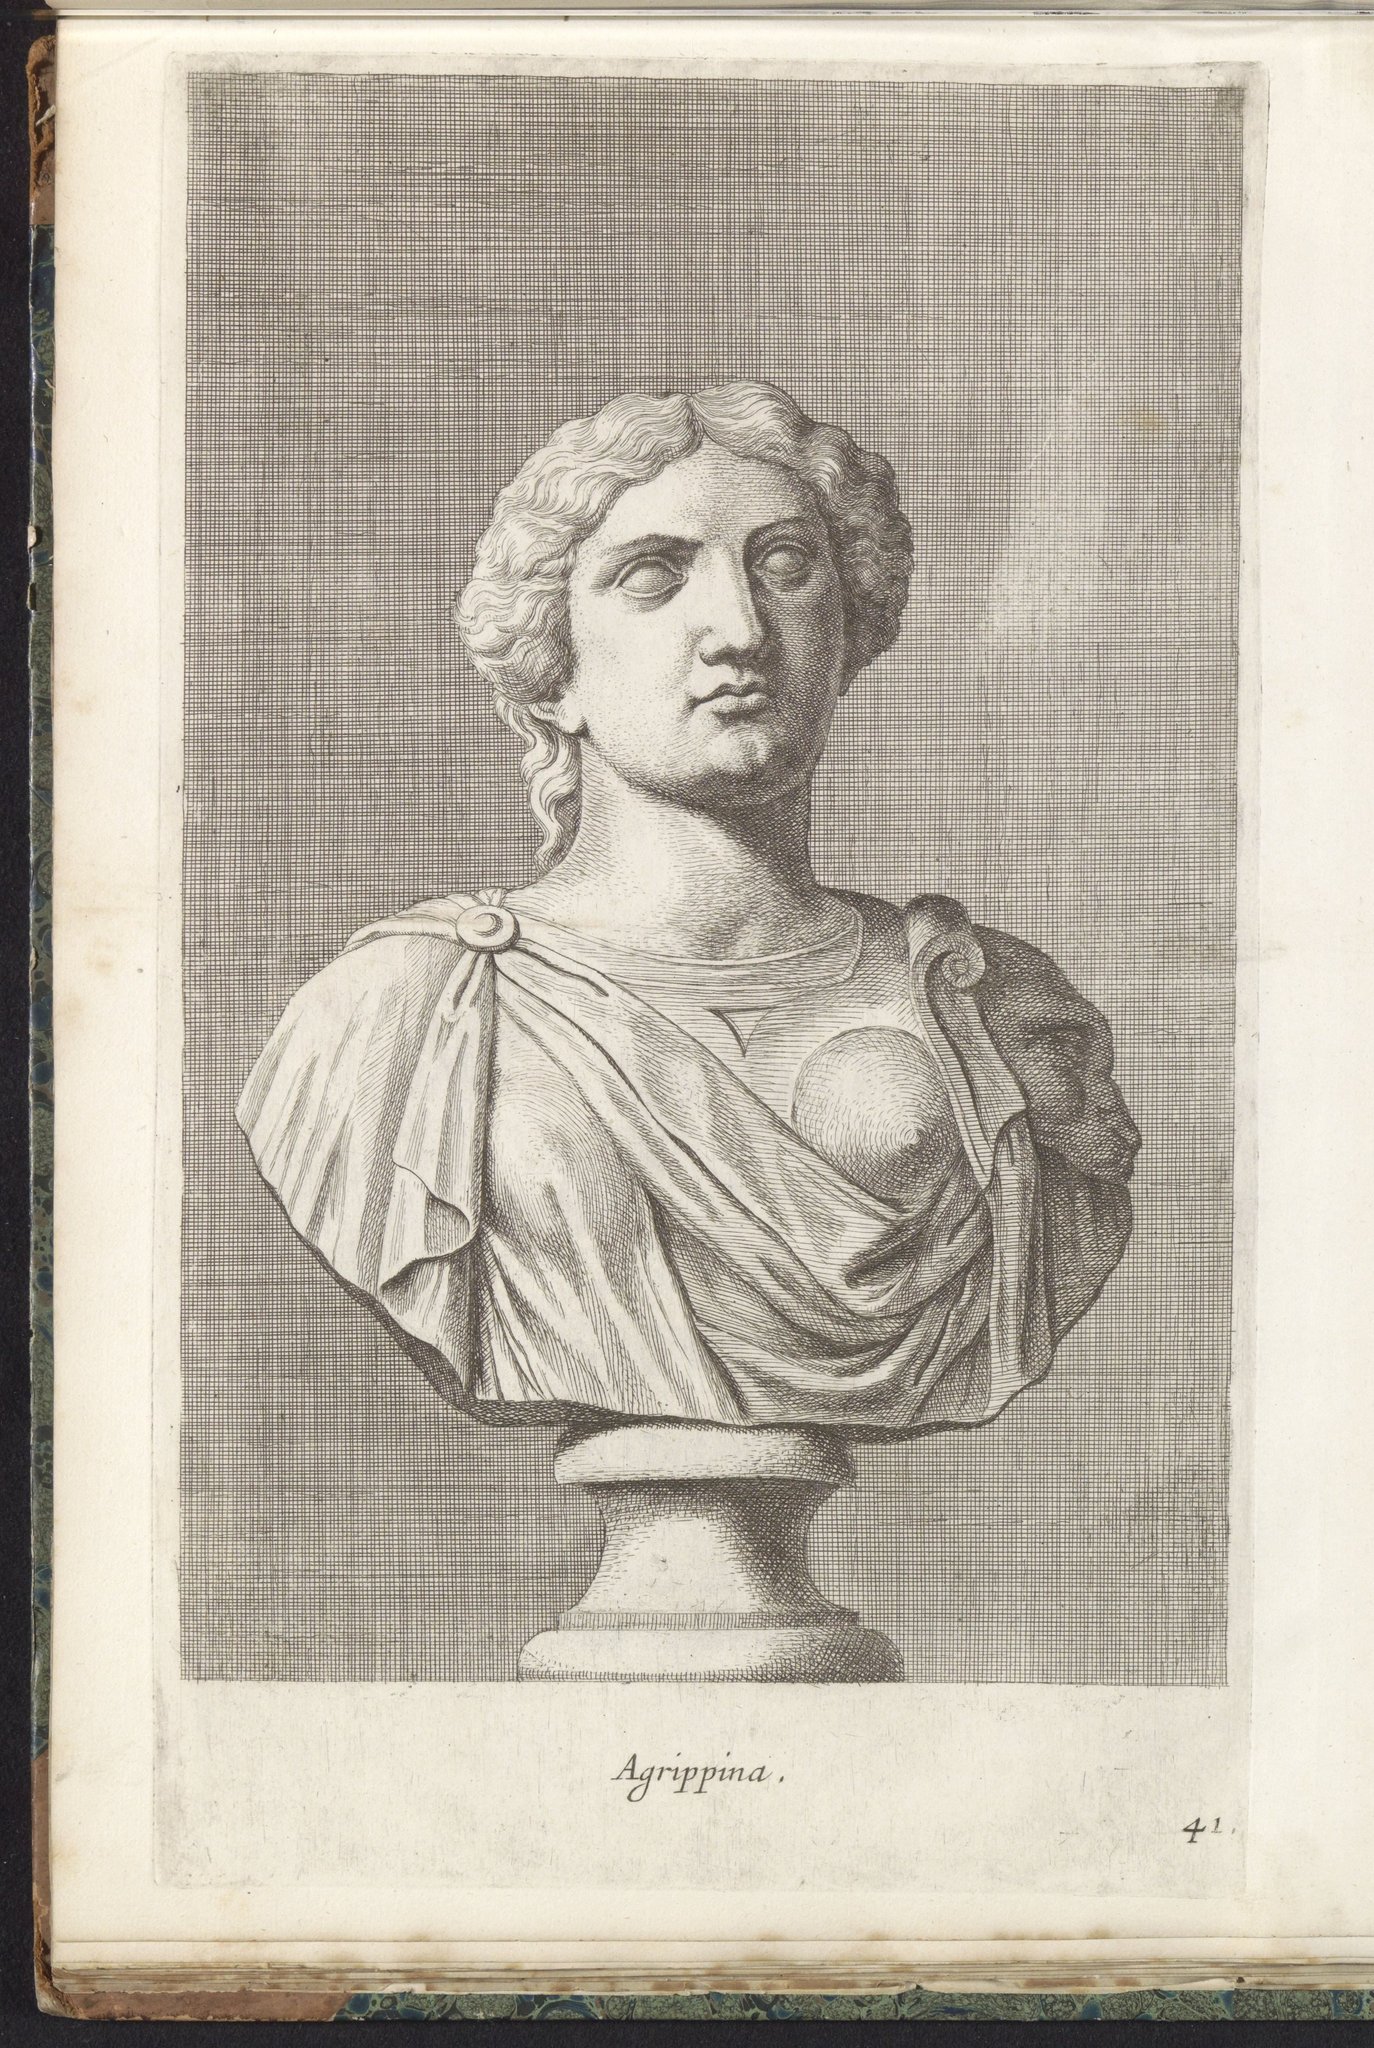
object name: album leaf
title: Buste van Agrippina de Jongere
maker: hubert quellinus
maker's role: print maker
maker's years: 1619-1687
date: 1646-1670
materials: paper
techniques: engraving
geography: antwerp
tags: piece of sculpture, reproduction of a piece of sculpture, female persons from classical history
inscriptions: number: ‘60’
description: Klassieke buste van een vrouw met borstharnas en een leeuw op haar linker schouder. De prent maakt deel uit van een album met een serie prenten naar de sculpturen in de verzameling van Gerard Reynst.